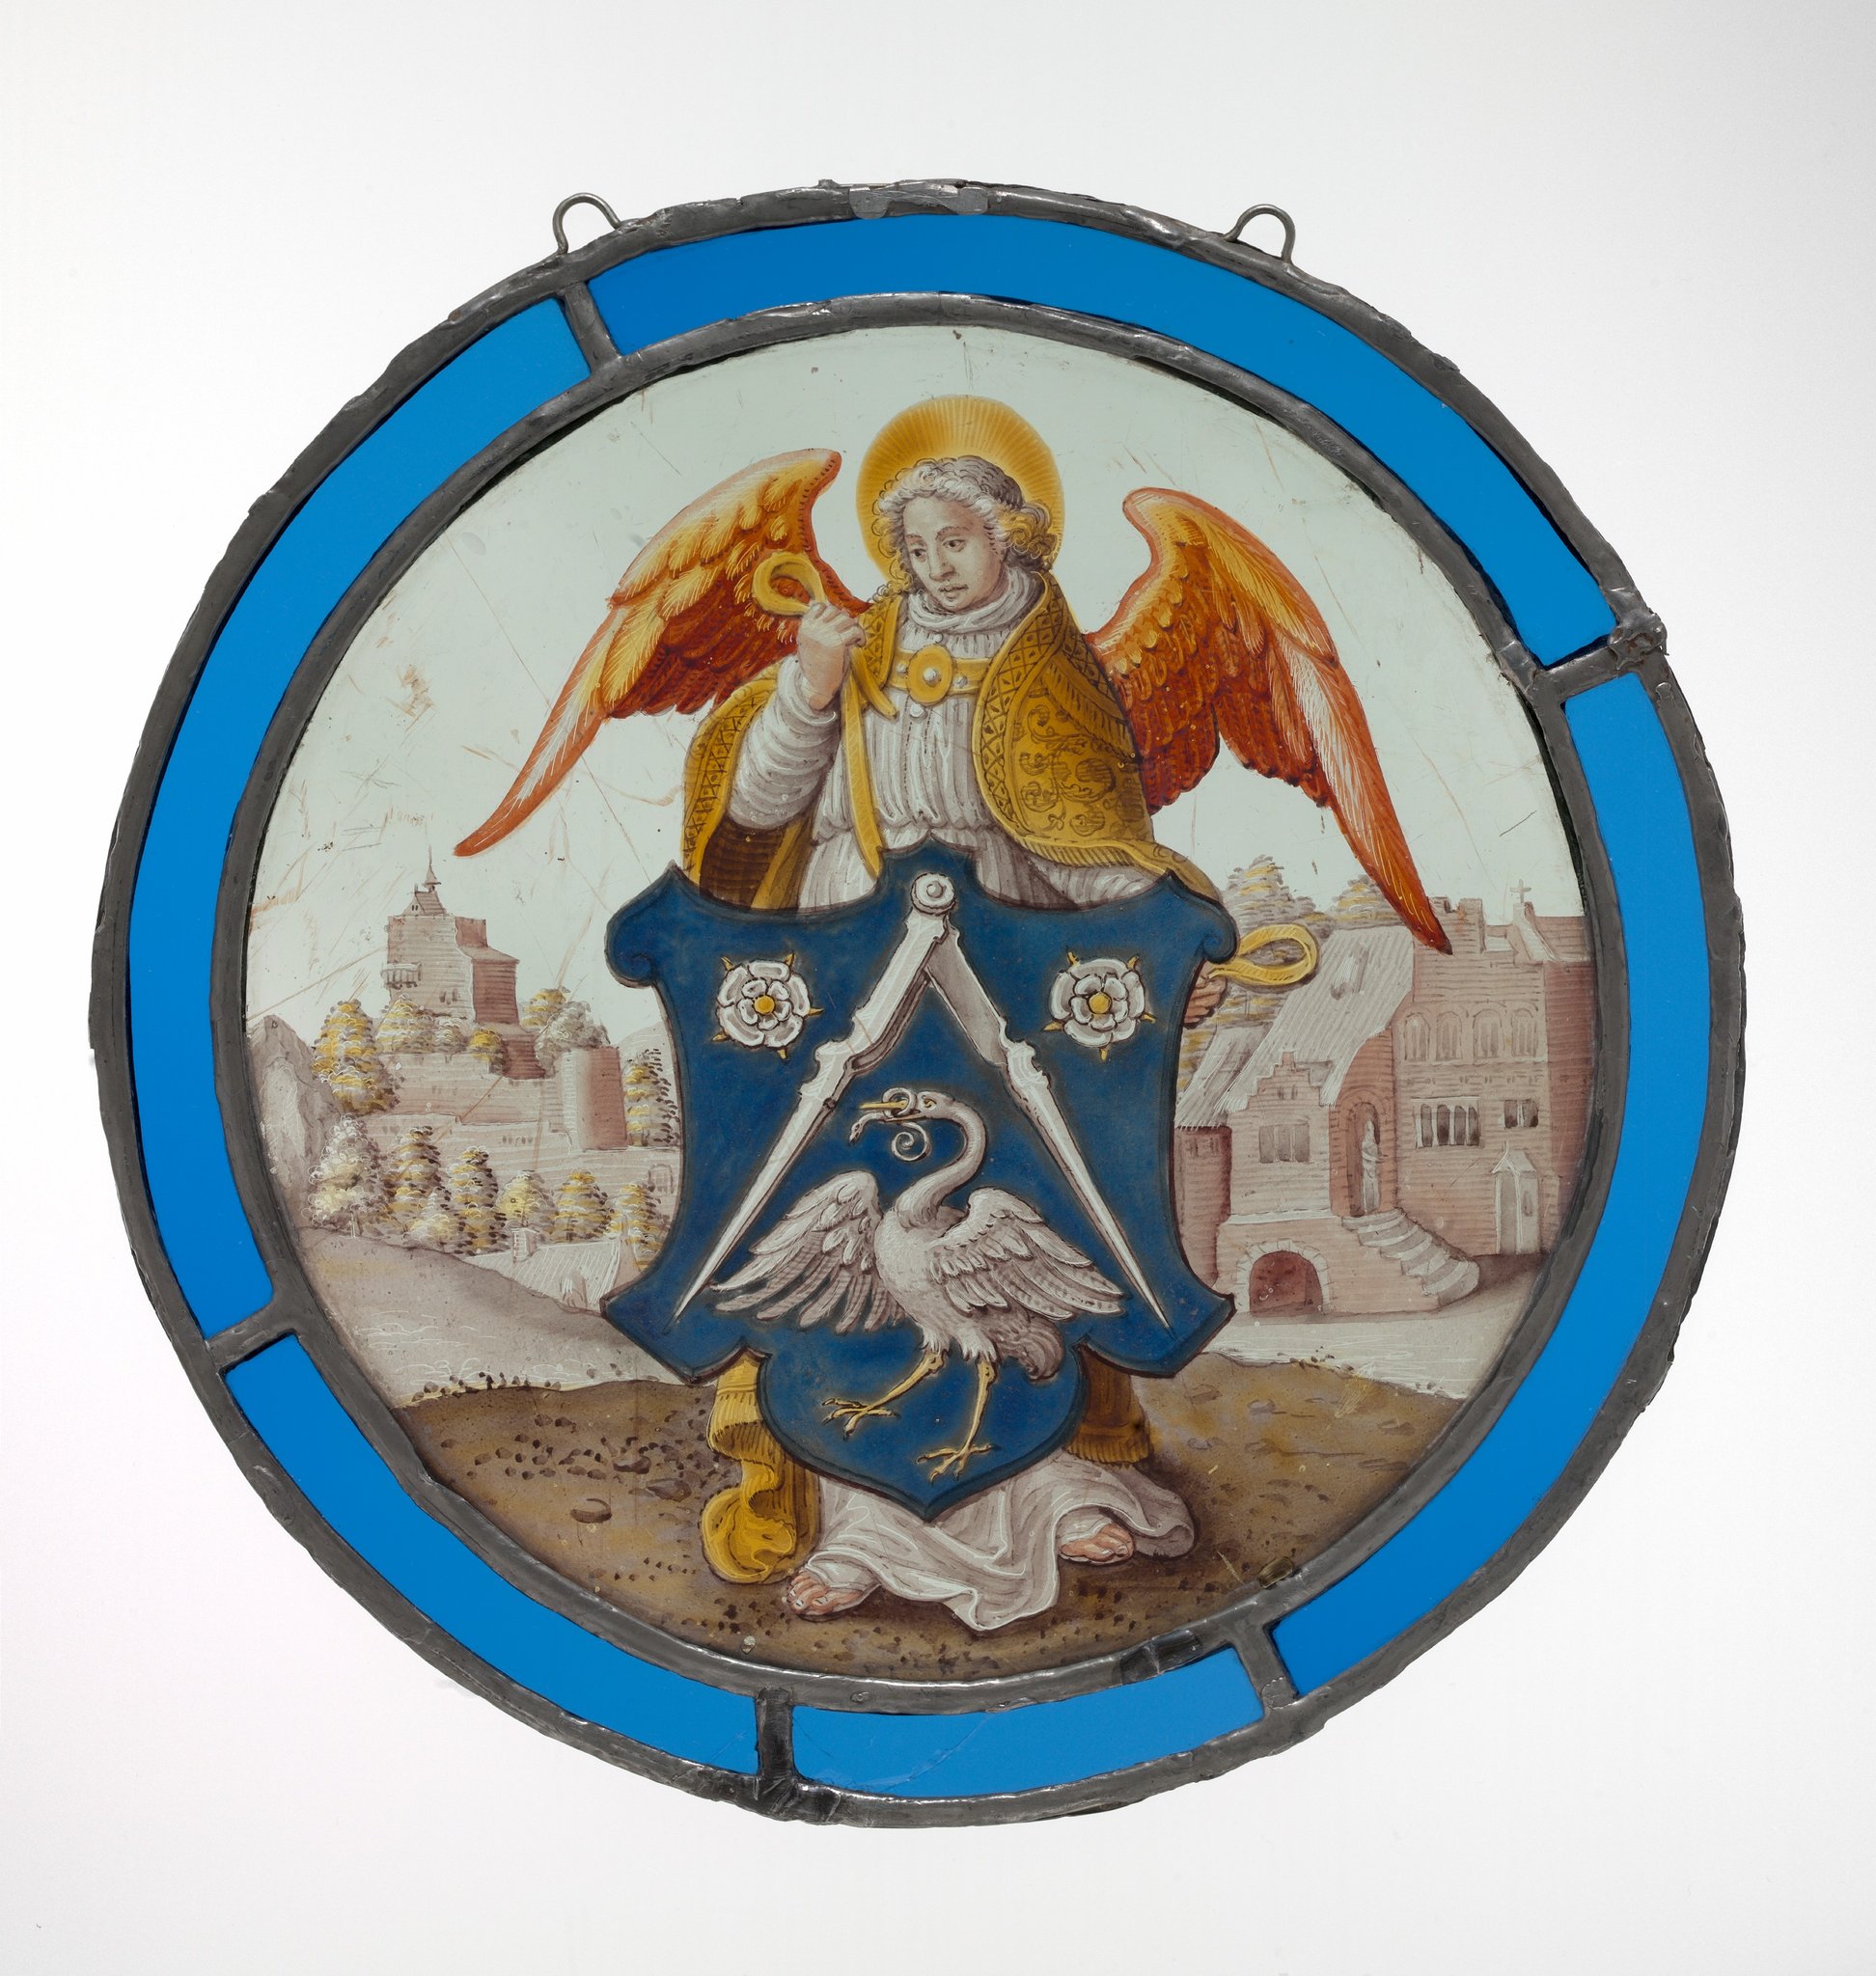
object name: roundel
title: Angel Supporting a Heraldic Shield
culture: south netherlandish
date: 1505-1515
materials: enamel, glass, paint, pigment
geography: south netherlands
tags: birds,angels,coat of arms